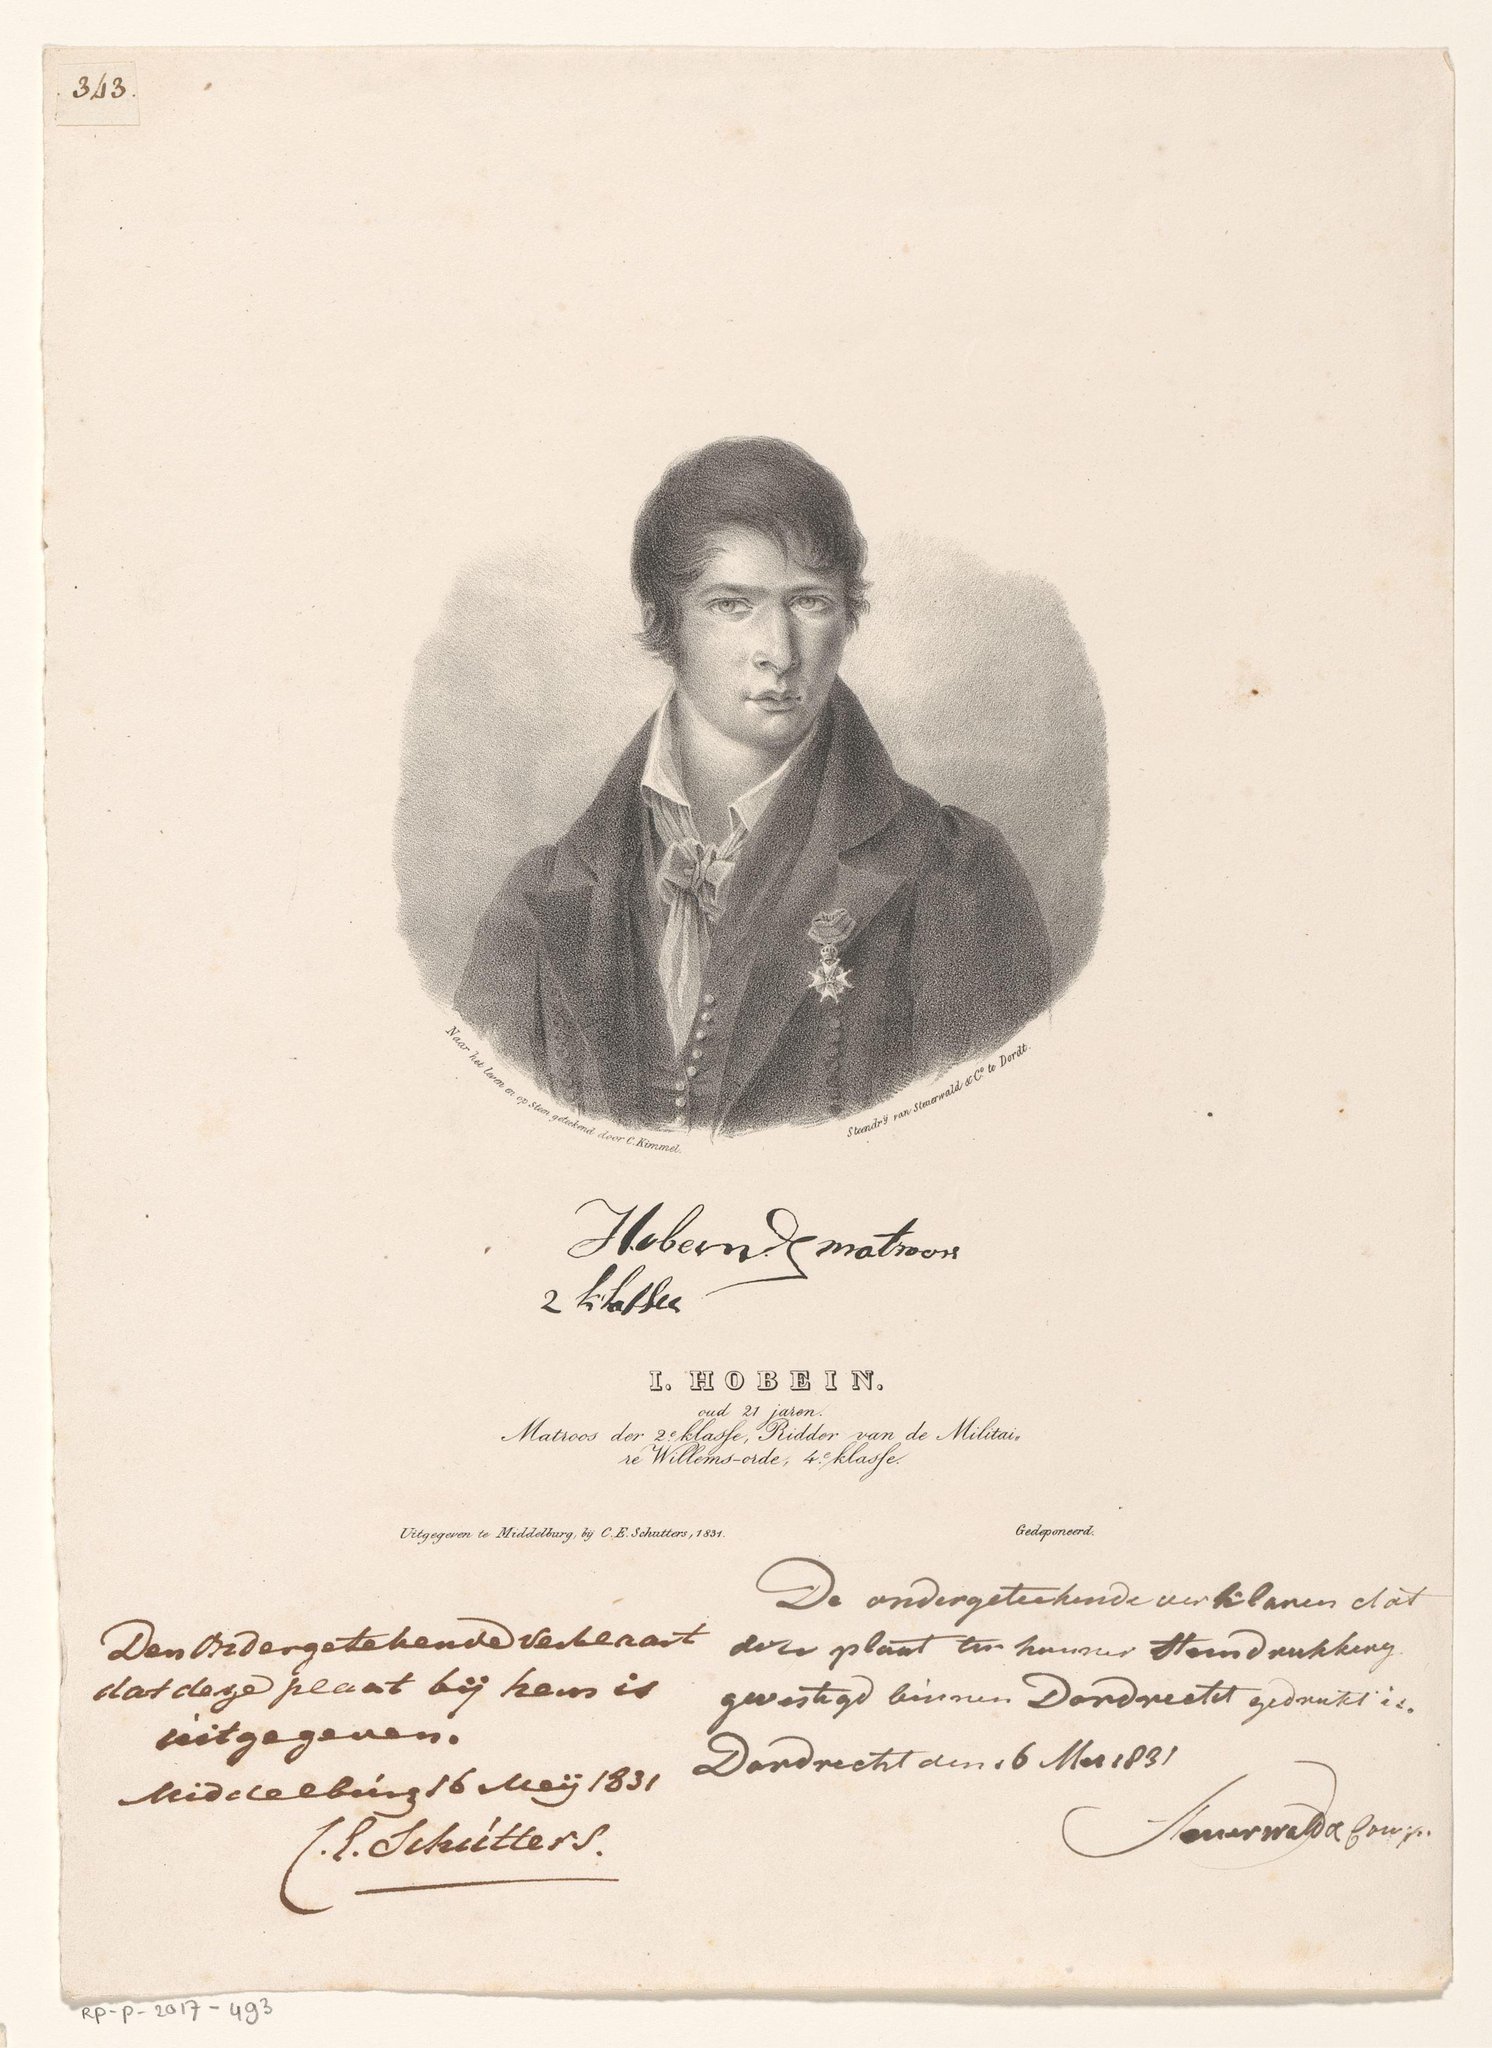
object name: print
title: Portret van Jacob Hobein op 21-jarige leeftijd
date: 1831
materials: paper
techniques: lithograph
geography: middelburg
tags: knighthood order, historical persons (+ (full) bust portrait)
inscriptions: : ‘Gedeponeerd.’, : ‘De ondergeteekende verklaren dat / deze plaat ter hunner steendrukkerij / gevestigd binnen Dordrecht gedrukt is. / Dordrecht den 16 Mei 1831 / Steuerwald & Comp’, : ‘Den ondergetekende verklaart / dat deze plaat bij hem is / uitgegeven. / Middelburg 16 meij 1831 / C.E. Schutters’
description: De geportretteerde draagt een ridderorde. Onder het portret zijn signatuur en titels.